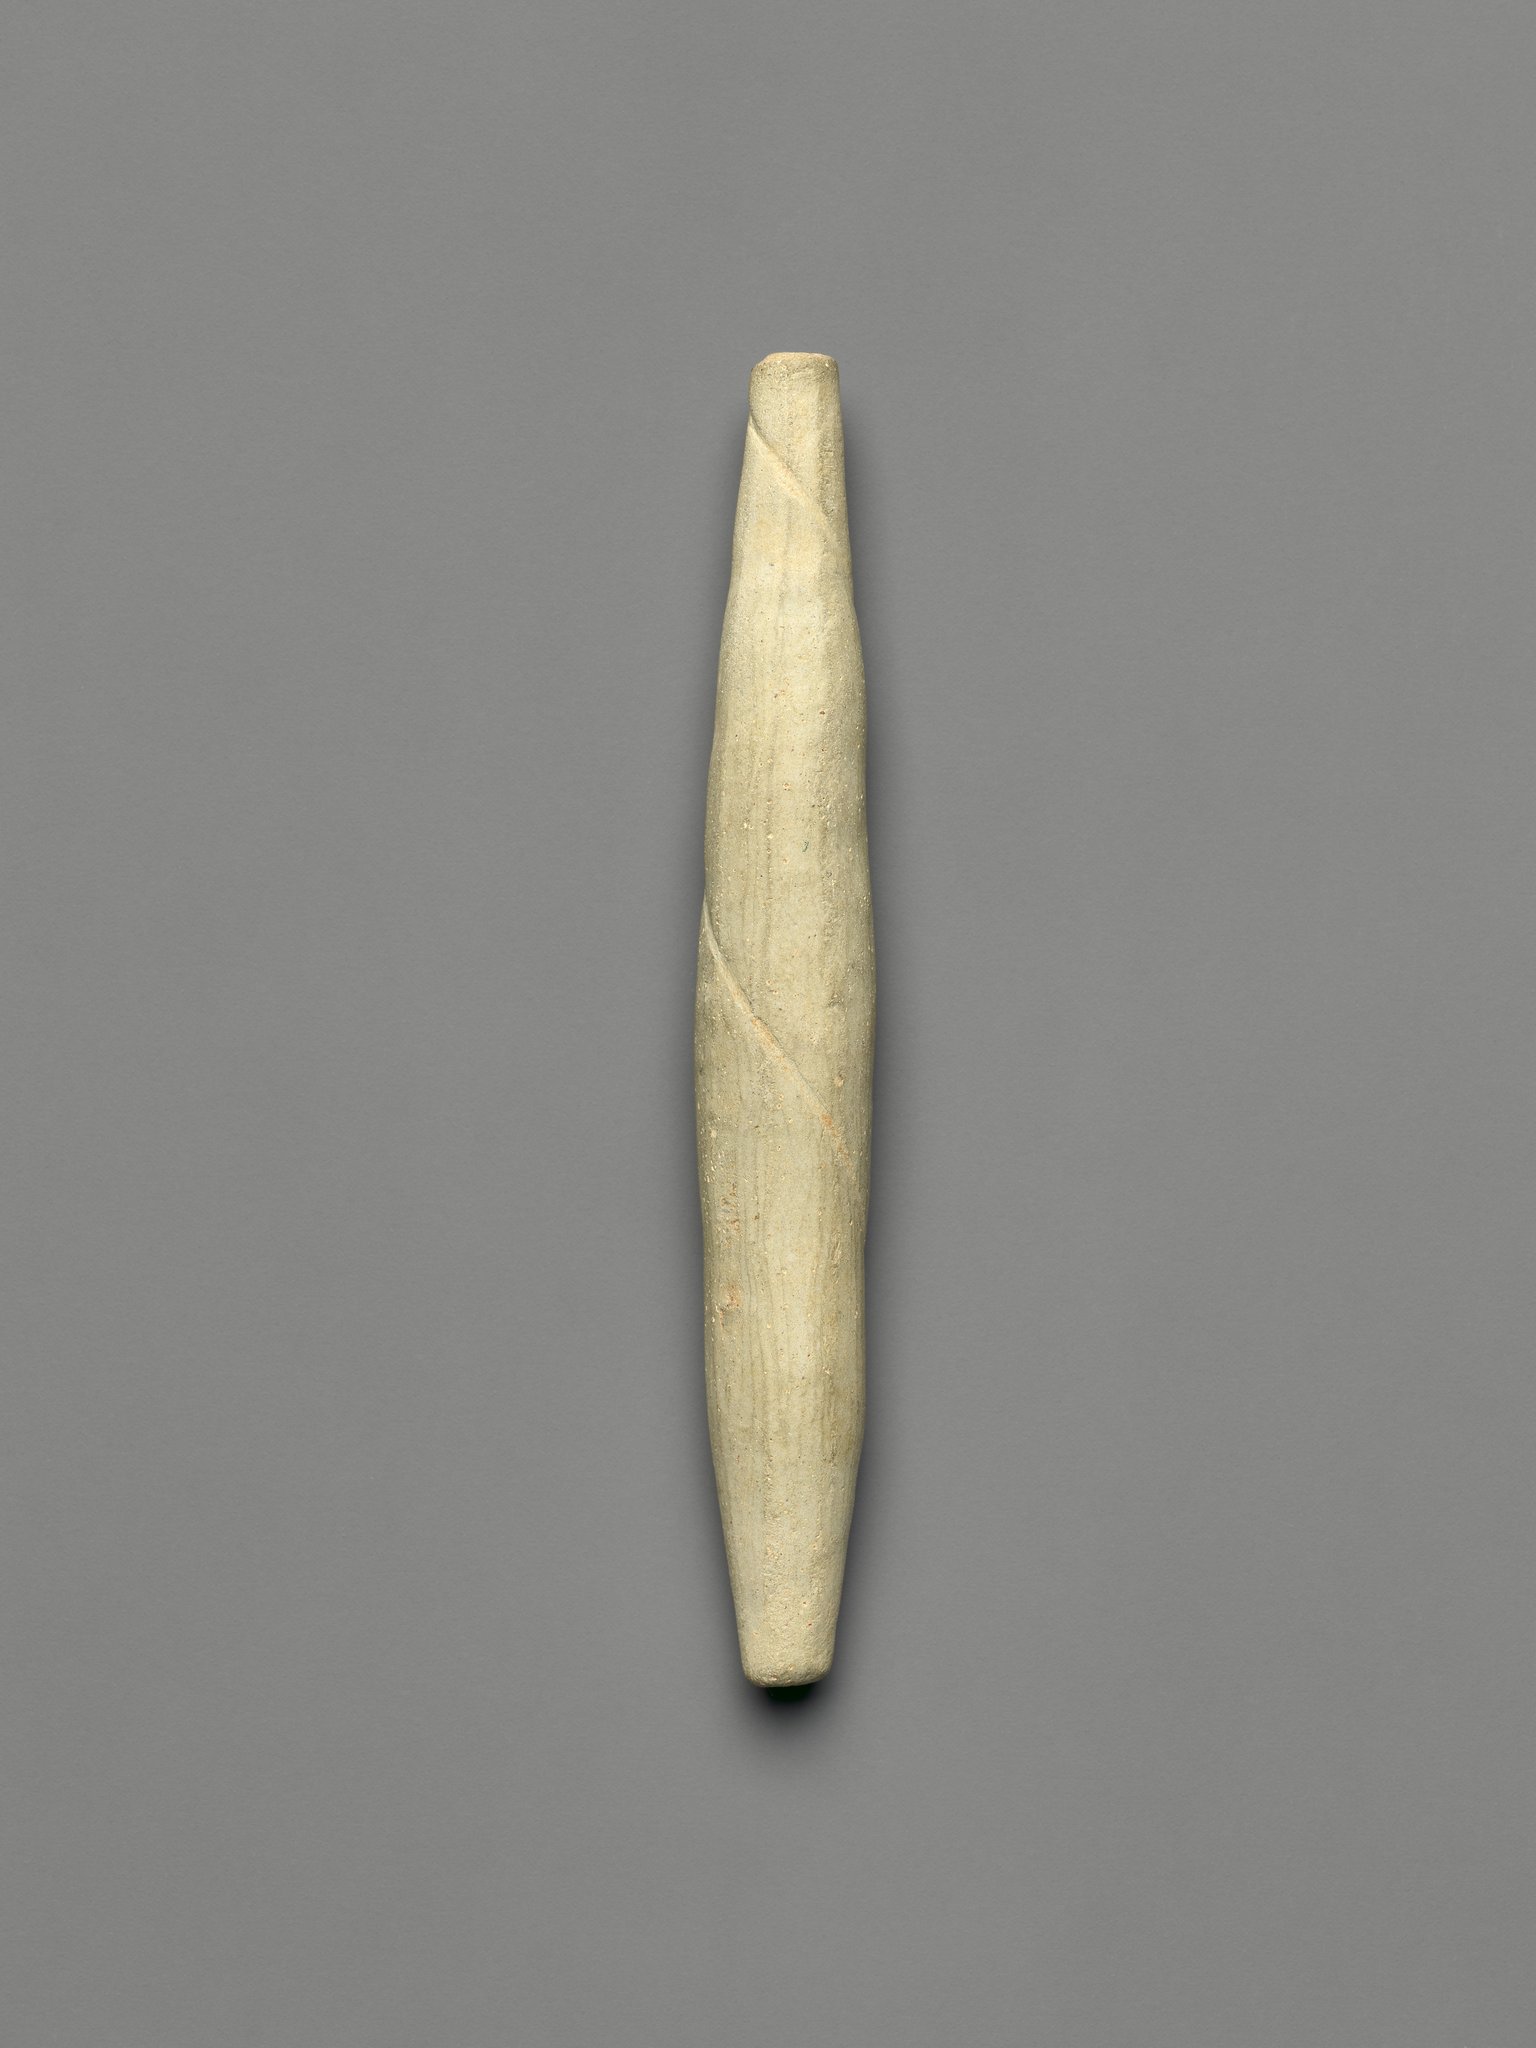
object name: bead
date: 3100-2900 BCE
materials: ceramic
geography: mesopotamia